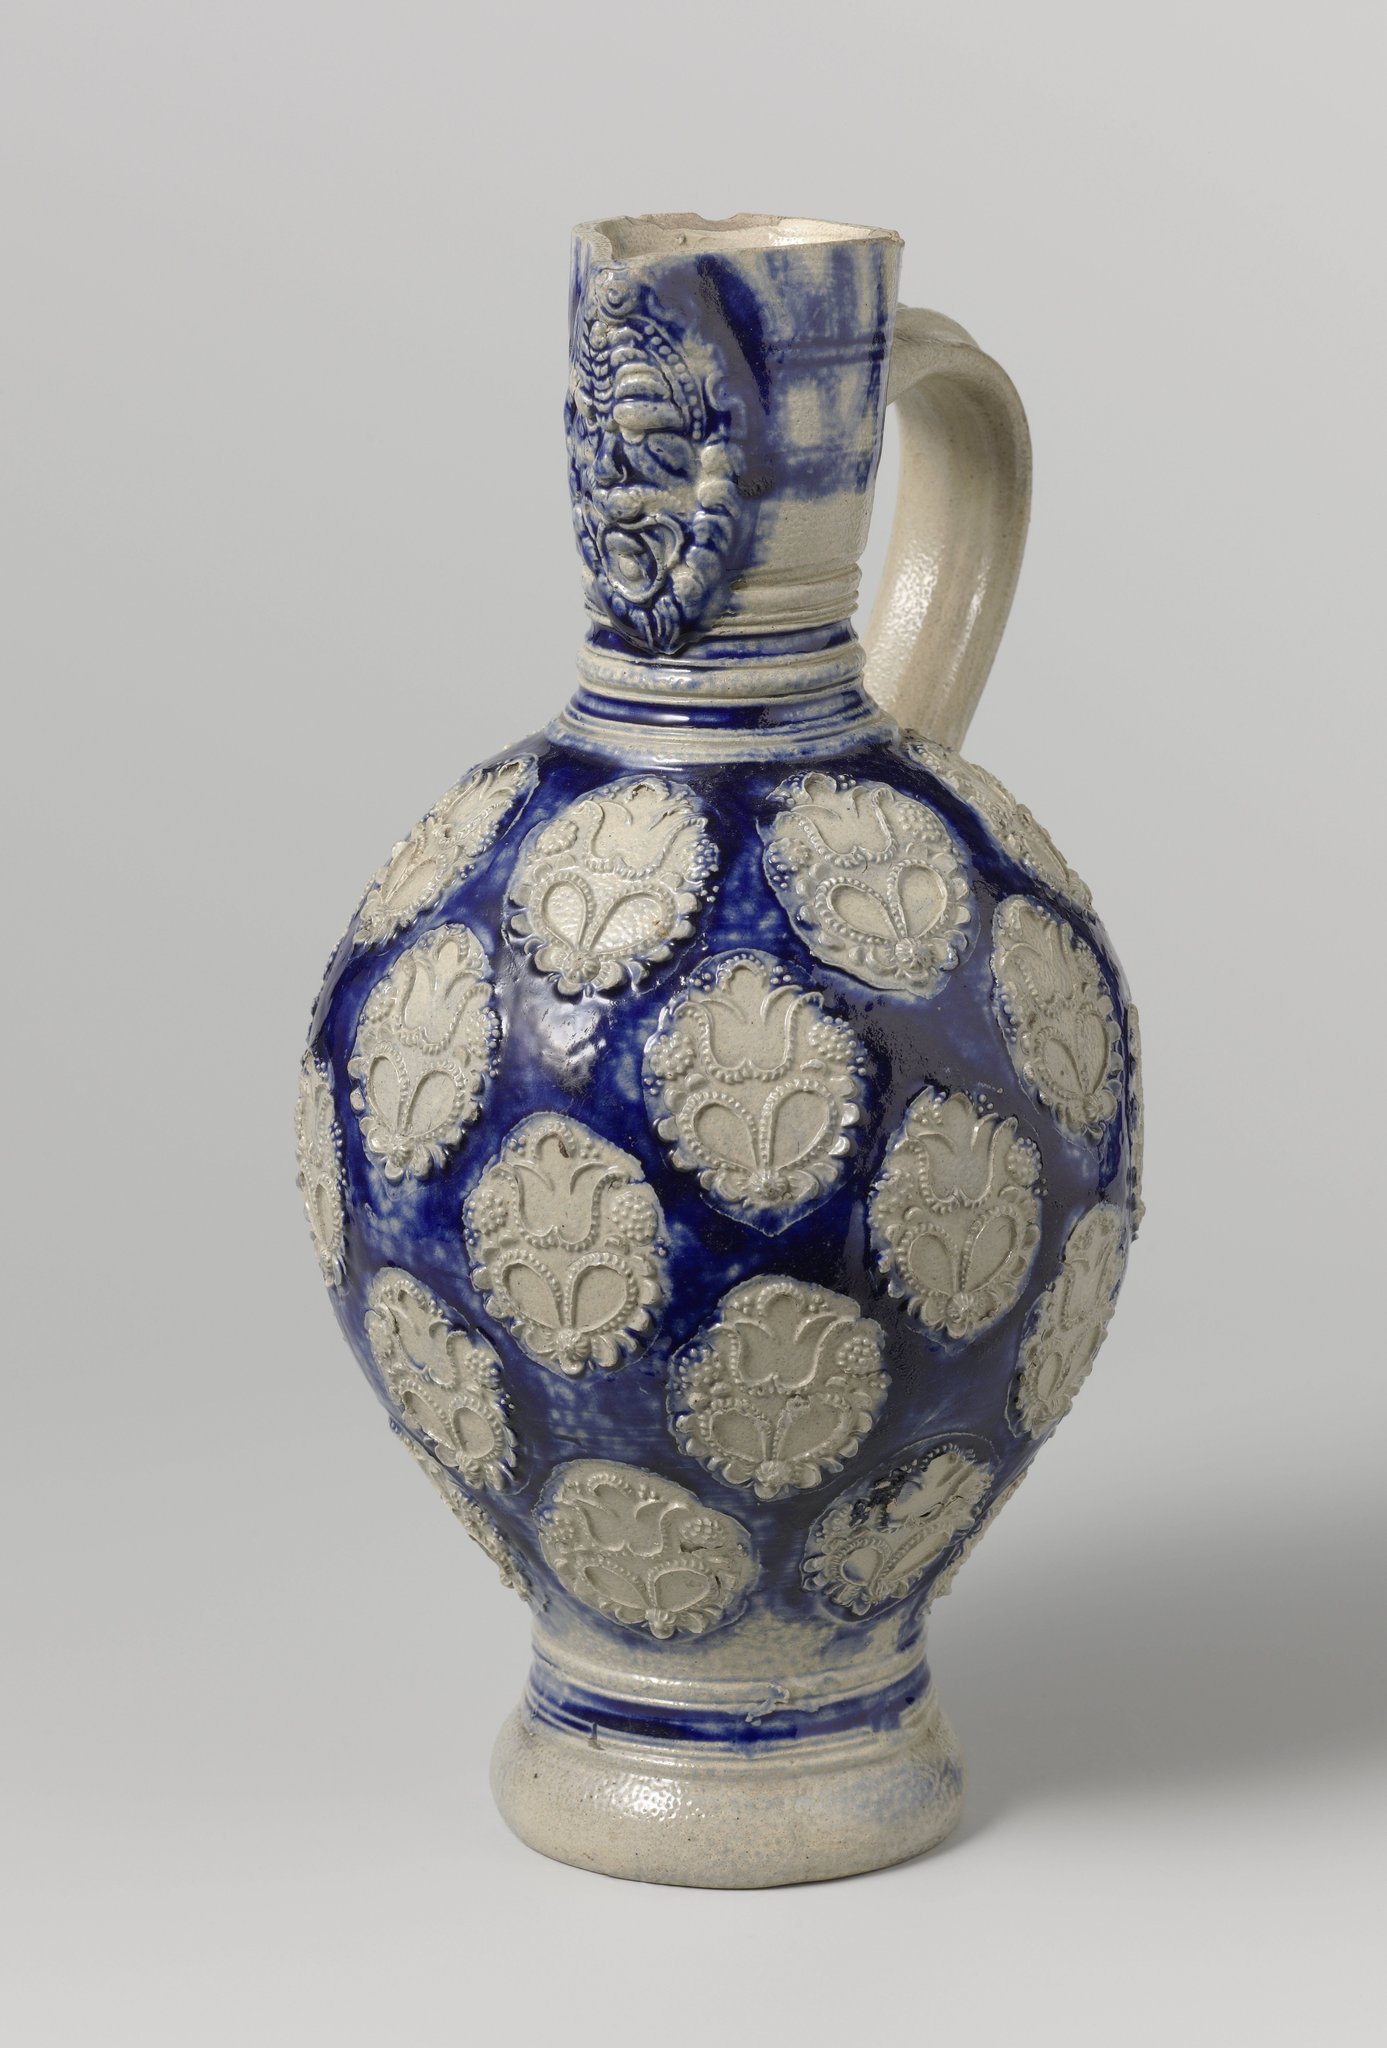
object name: ewer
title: Jug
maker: Anonymous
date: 1650-1699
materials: cobalt, glaze, stoneware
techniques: firing, forming, relief, turning, vitrification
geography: westerwald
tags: mask, mascaron ~ ornament, ornament derived from plant forms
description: Kan van steengoed op hoge voet met een smalle nek, eivormig lichaam en in de rand een geknepen tuit. Het C-vormige oor is bevestigd aan de nek en de schouder. Gedeeltelijk bedekt met kobaltblauw. Op de voet en de nek enkele profielen. De kan is versierd met een reliëfdecoratie waarbij de buik is bedekt met vijf rijen van gedrukte, opgelegde medaillons met een gestileerde bloem tegen een blauwe achtergrond. Op de nek onder de tuit is een gemodelleerde leeuwenkop aangebracht. Westerwald.